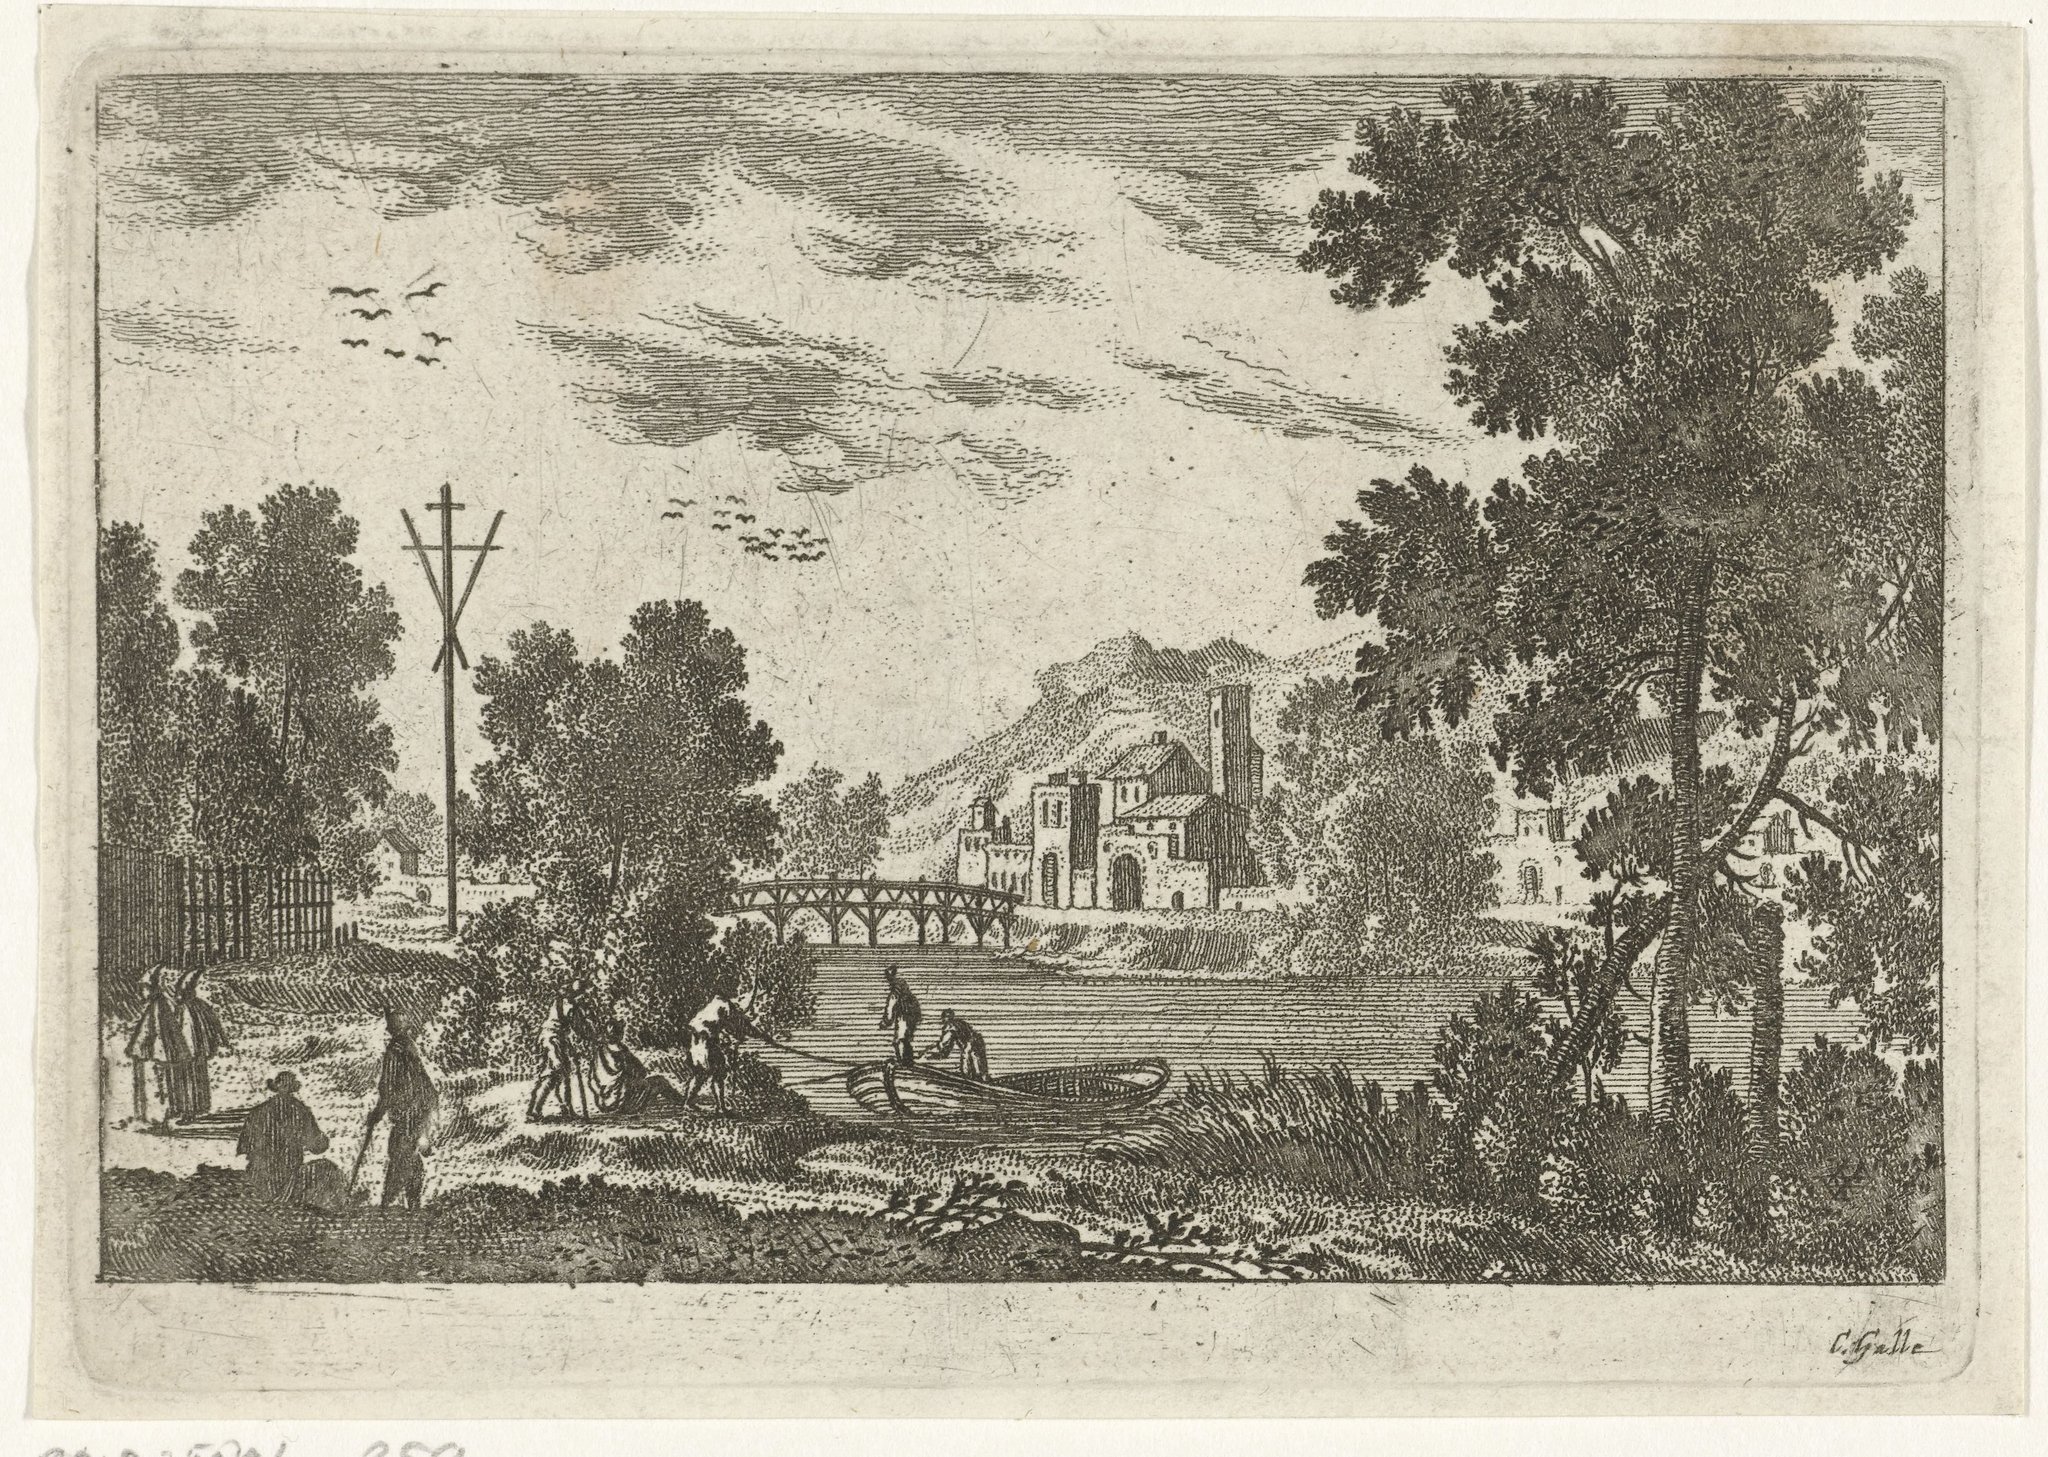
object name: print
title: Rivierlandschap met trekschuit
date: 1638-1678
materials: paper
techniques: engraving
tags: landscapes with waters, waterscapes, seascapes (in the temperate zone), boat propelled by man or animal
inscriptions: collector's mark: Lugt 2228